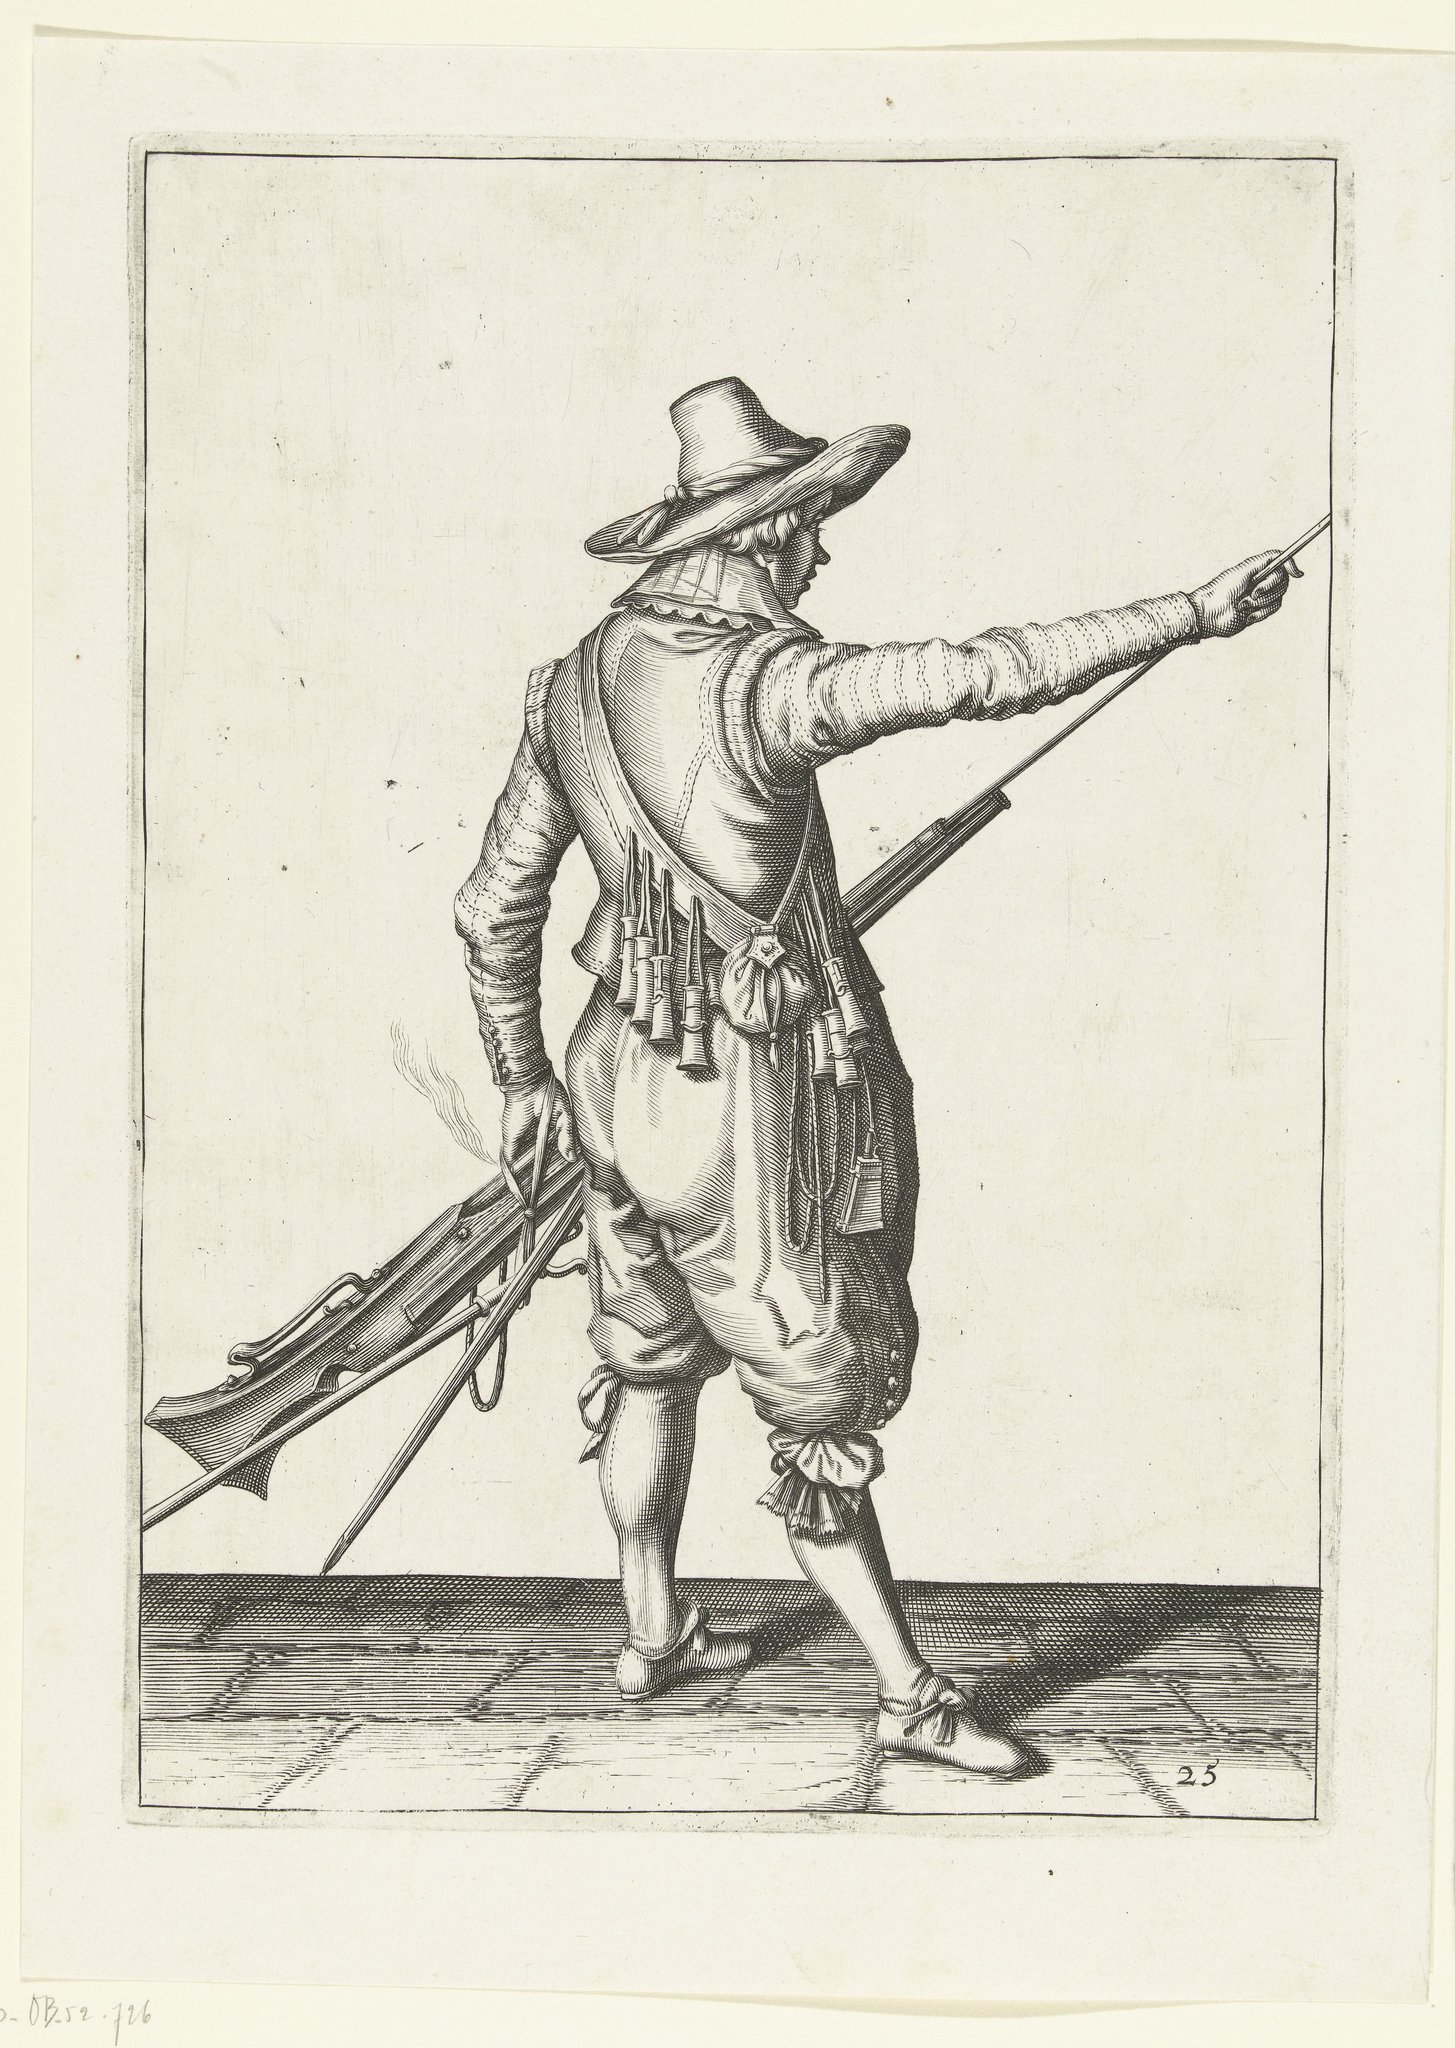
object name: print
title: Soldaat die zijn laadstok uit de houder onder de loop van zijn musket haalt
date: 1597-1607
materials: paper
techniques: engraving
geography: netherlands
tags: manoeuvre ~ military training, firearms: rifle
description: Een soldaat, ten voeten uit, naar rechts, op de rug gezien, die met zijn linkerhand bij zijn linkerdijbeen een musket (een bepaald type vuurwapen) vasthoudt en met zijn rechterhand de laadstok uit de houder onder de loop haalt. In zijn linkerhand behalve het musket ook een brandende lont; aan zijn linkerpols een furket (musketvork). Deze prent is onderdeel van de reeks van 43 genummerde prenten van musketiers uit de Wapenhandelinghe.